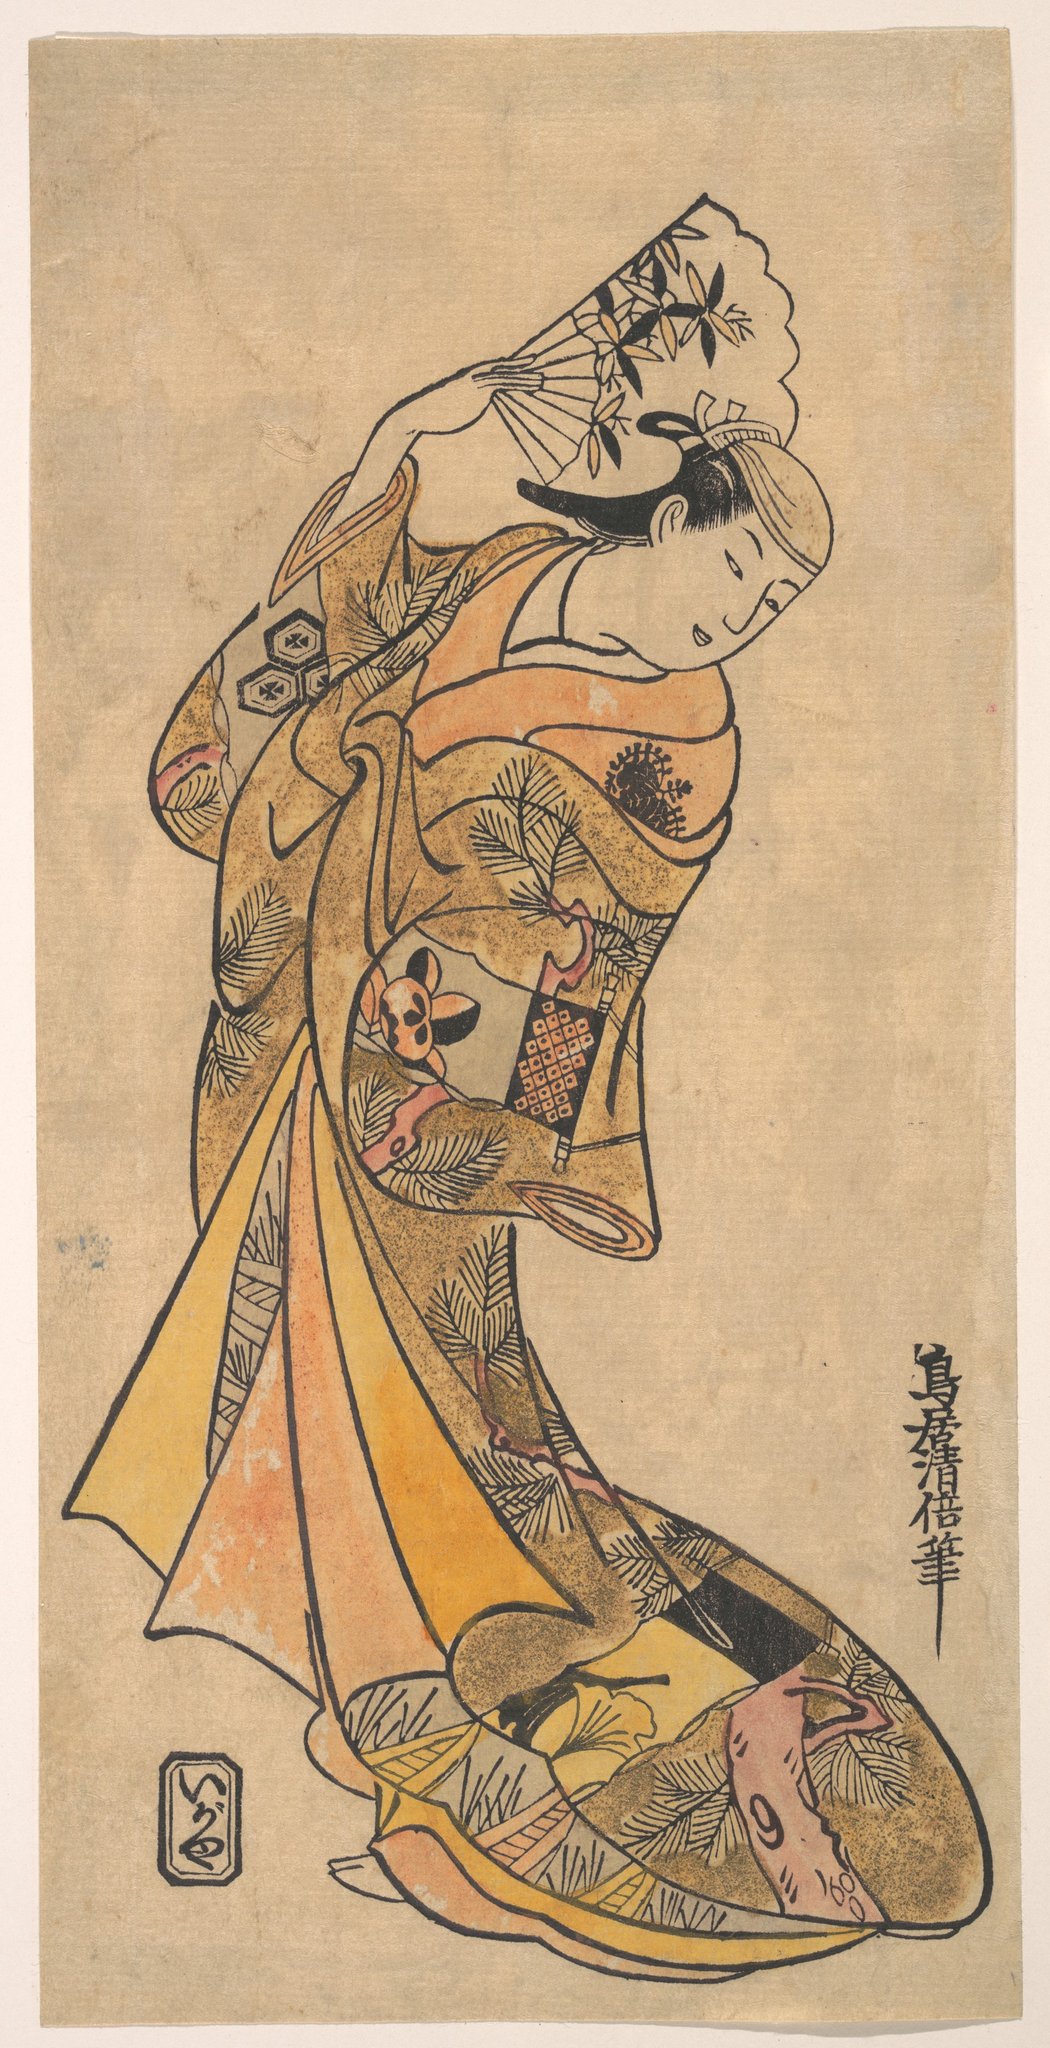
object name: print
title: The Actor, Nakamura Shichisaburo II, 1703–1774 as a Woman with Fan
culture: japanese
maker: torii kiyomasu ii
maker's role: artist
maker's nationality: japanese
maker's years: 1706-1763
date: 1706-1763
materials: ink, paper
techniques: woodblock print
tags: fans,men,actors